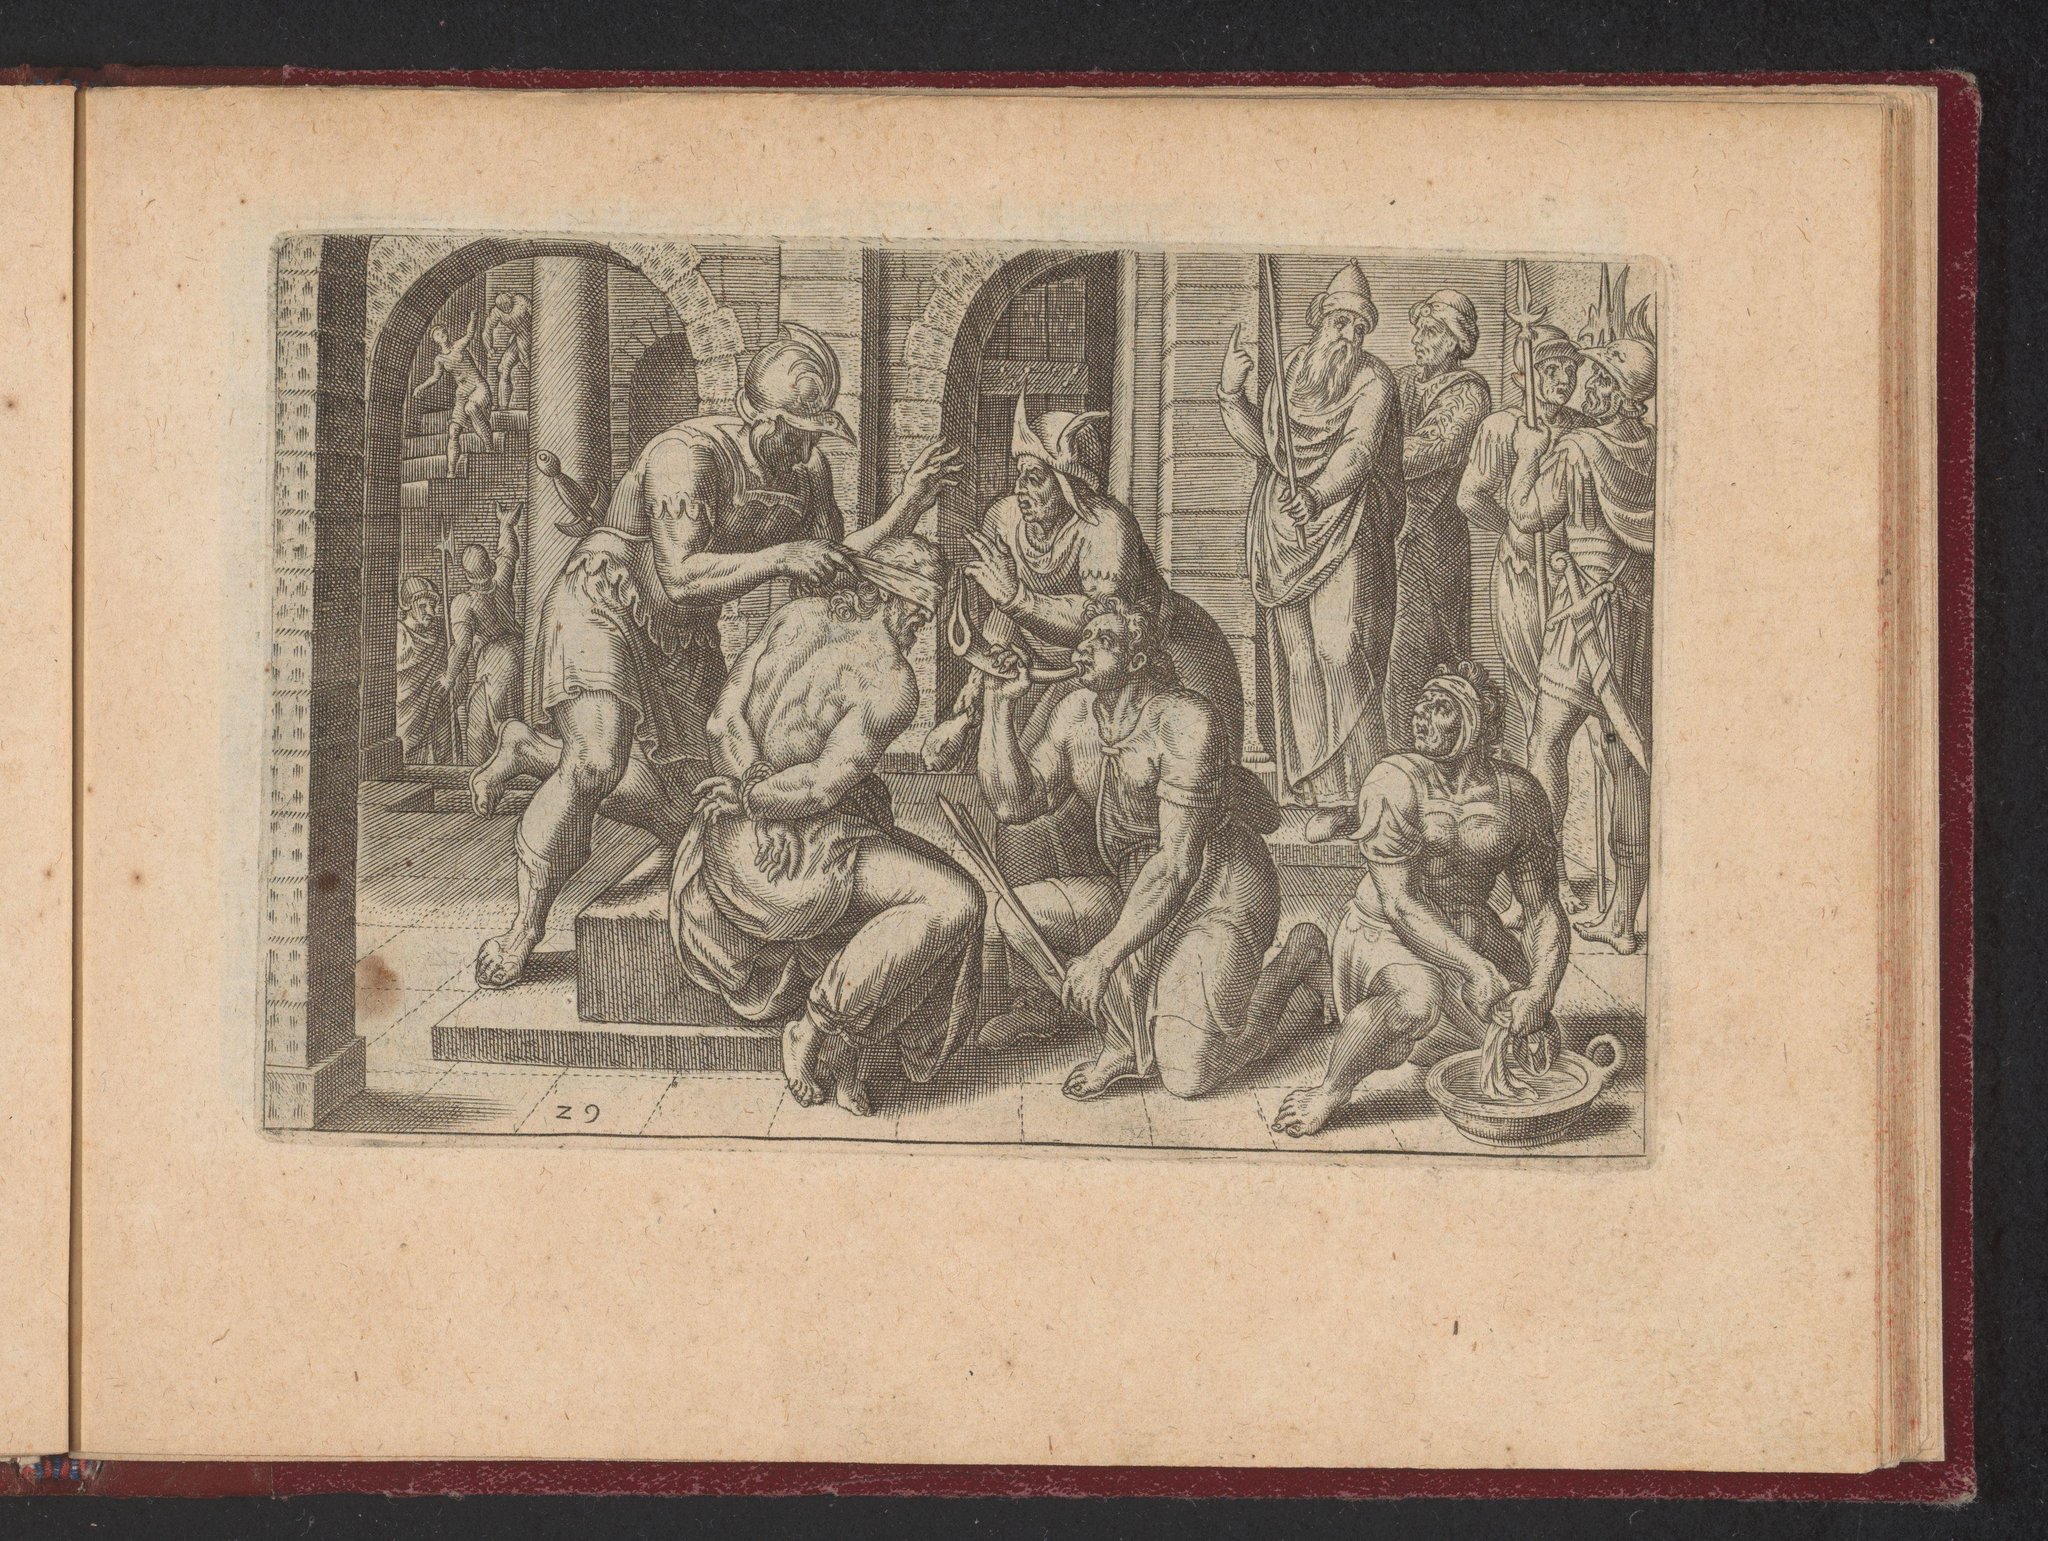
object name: print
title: Christi Iesu vitae admirabiliumque actionum speculum a Philippo Gallaeo apparatum Bened. Ariae Montani singuloribus distichis instructum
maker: philips galle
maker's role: print maker, publisher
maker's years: 1537-1612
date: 1573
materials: paper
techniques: engraving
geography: antwerp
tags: mockings of christ, who may be blindfolded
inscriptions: watermark: ‘gotische letter P’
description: Onderdeel van een album met een titelprent en een serie van 50 prenten betreffende het leven en de passie van Christus.